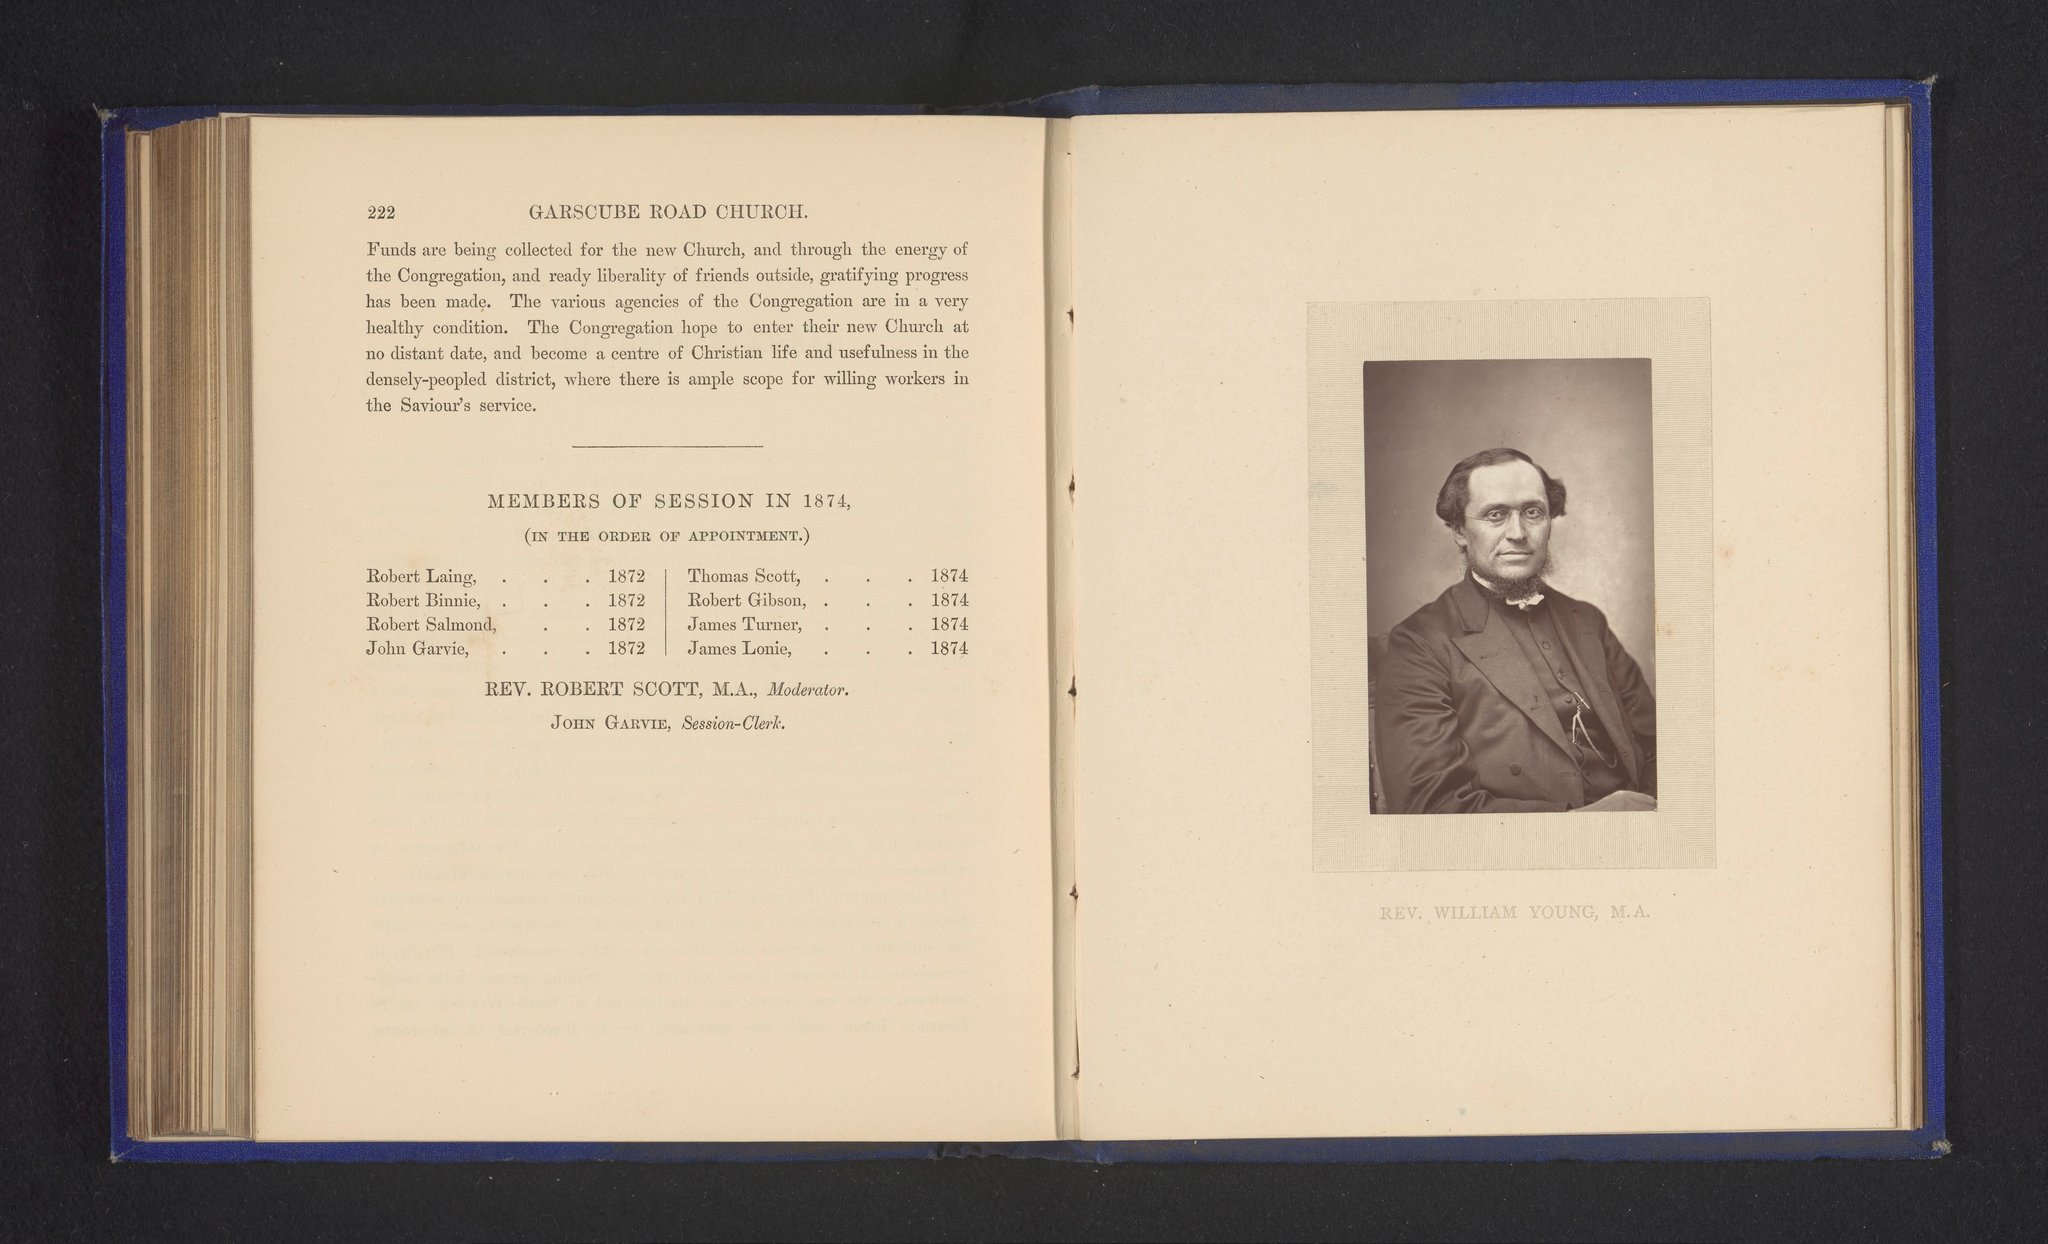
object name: page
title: Portret van William Young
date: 1865-1875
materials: paper, photographic support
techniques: carbon print, woodburytype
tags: functionaries and dignitaries (with name) ~ protestant churches